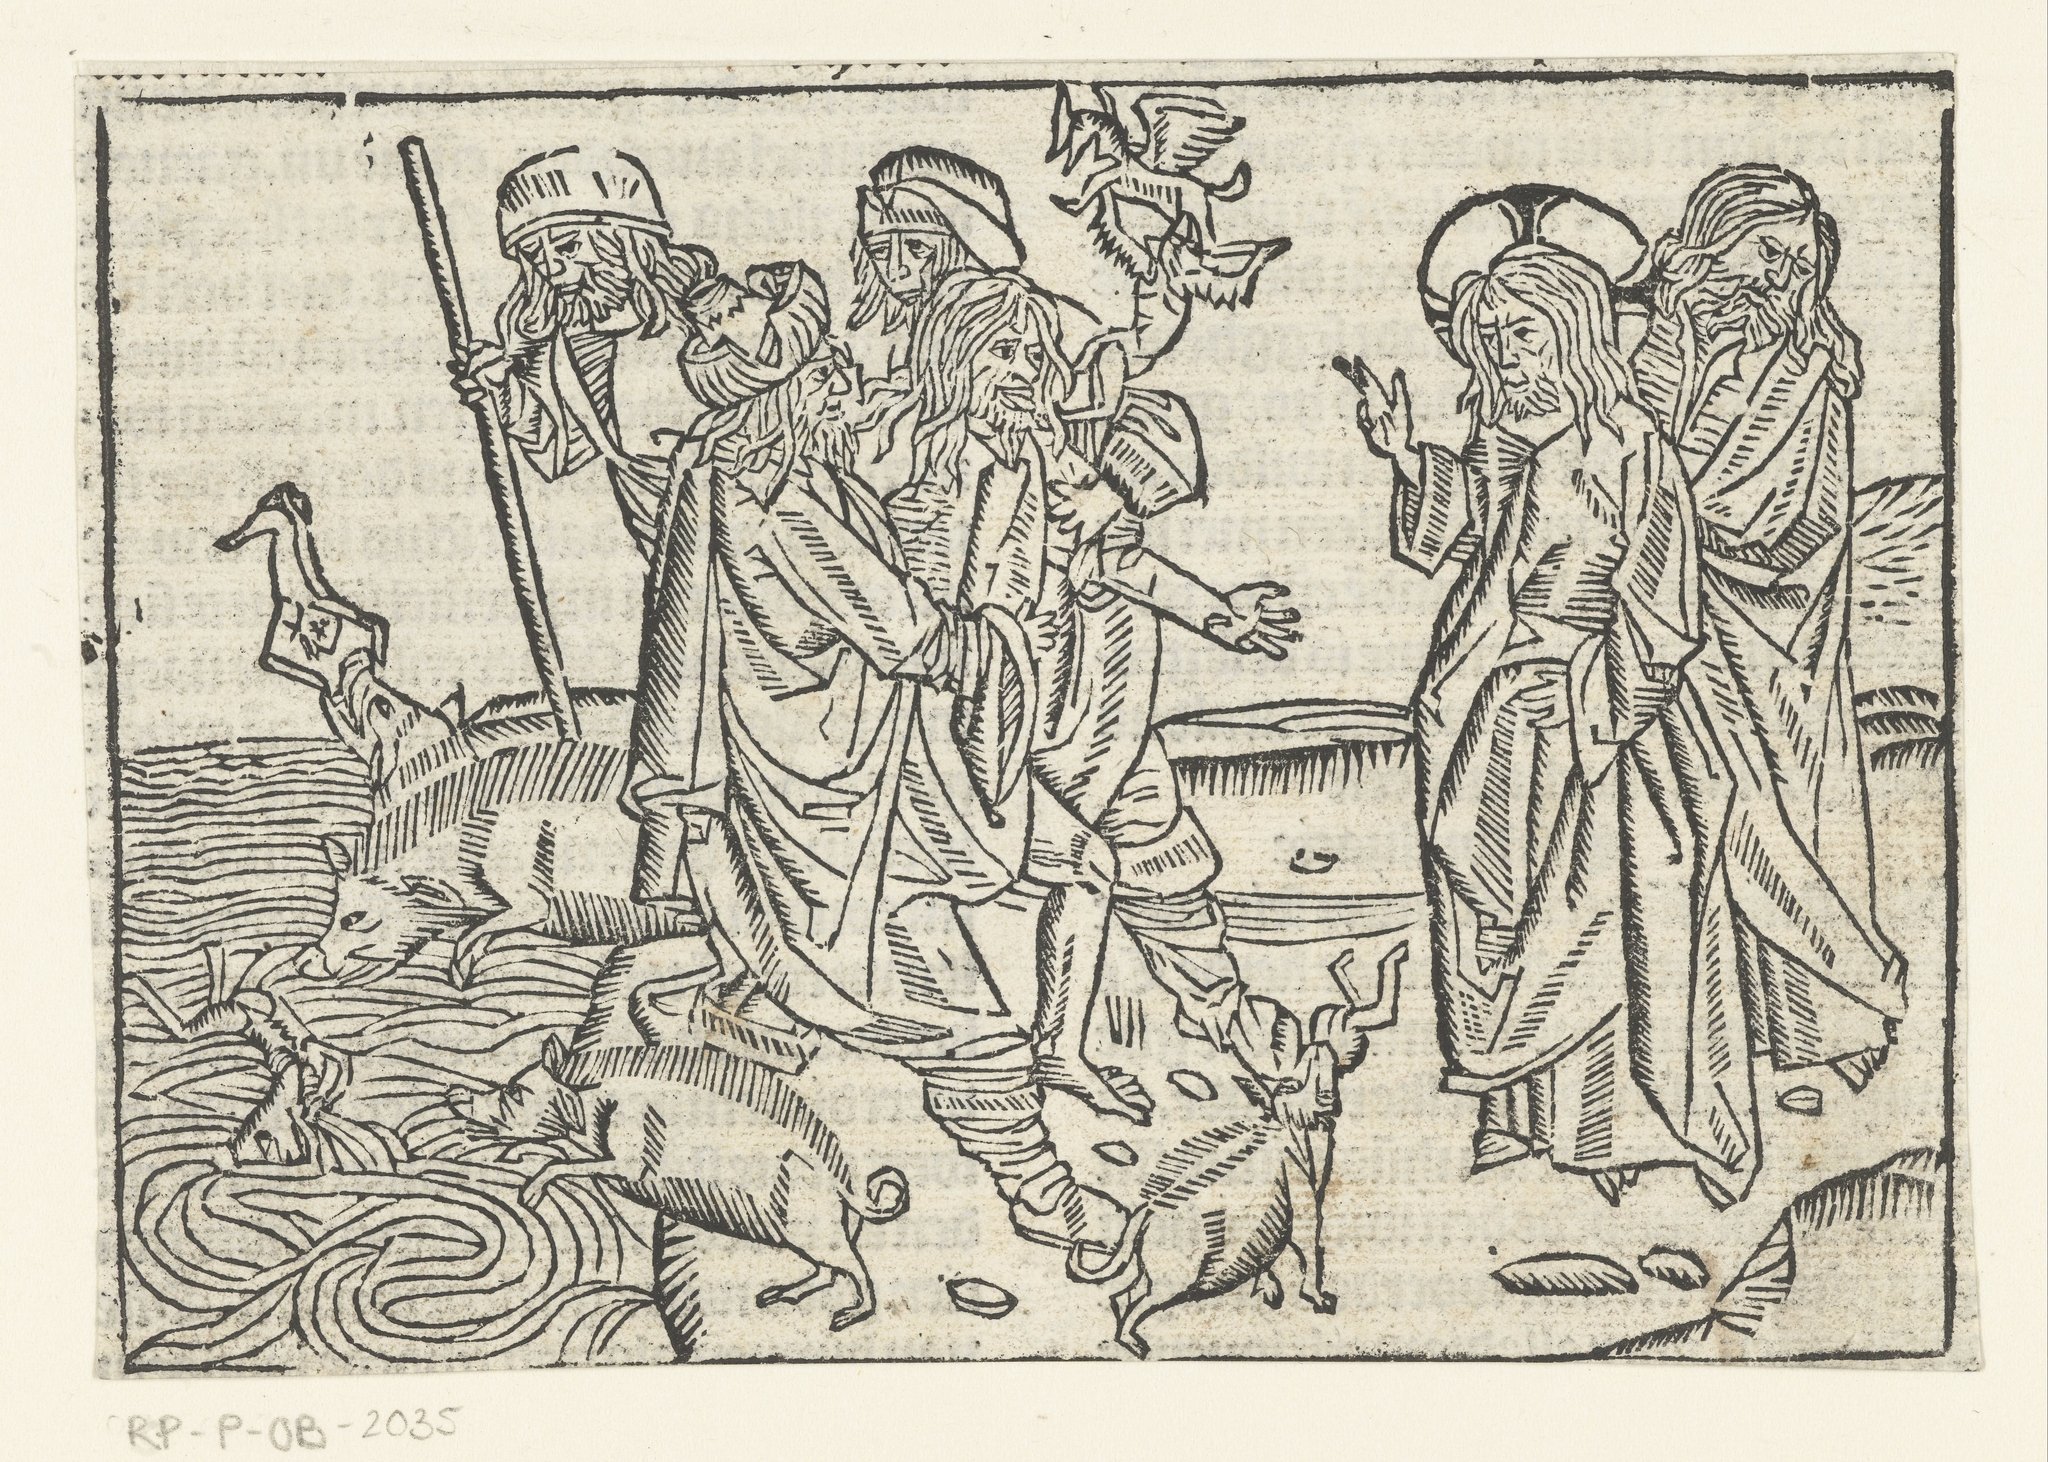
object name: book illustration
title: Christus geneest bezeten man in het gebied van de Gerasenen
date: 1480-1500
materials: paper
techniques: woodcut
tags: the demons enter into a herd of swine, which leap into the sea ~ healing of two possessed at gerasa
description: Eén blad van 113 uit Ludolphus de Saxonia, "Dit es dleué ons liefs heeren ihesu christi". Anonieme Nederlandse vertaling. Uitgegeven door Henrick Eckert van Homberch te Antwerpen in 1503. Botke, K. Deze 113 houtsneden, die meestal reeds in vroege Nederlandse boeken gebruikt zijn, worden toegeschreven aan de tweede Meester van Delft, de Meester van de Delbecq-Schreiber-passie en de Meester van de Virgo inter Virgines. In Conway (1884) en in "De gulden passer"(1951) zijn ook eerdere versies opgenomen. Botke, K.